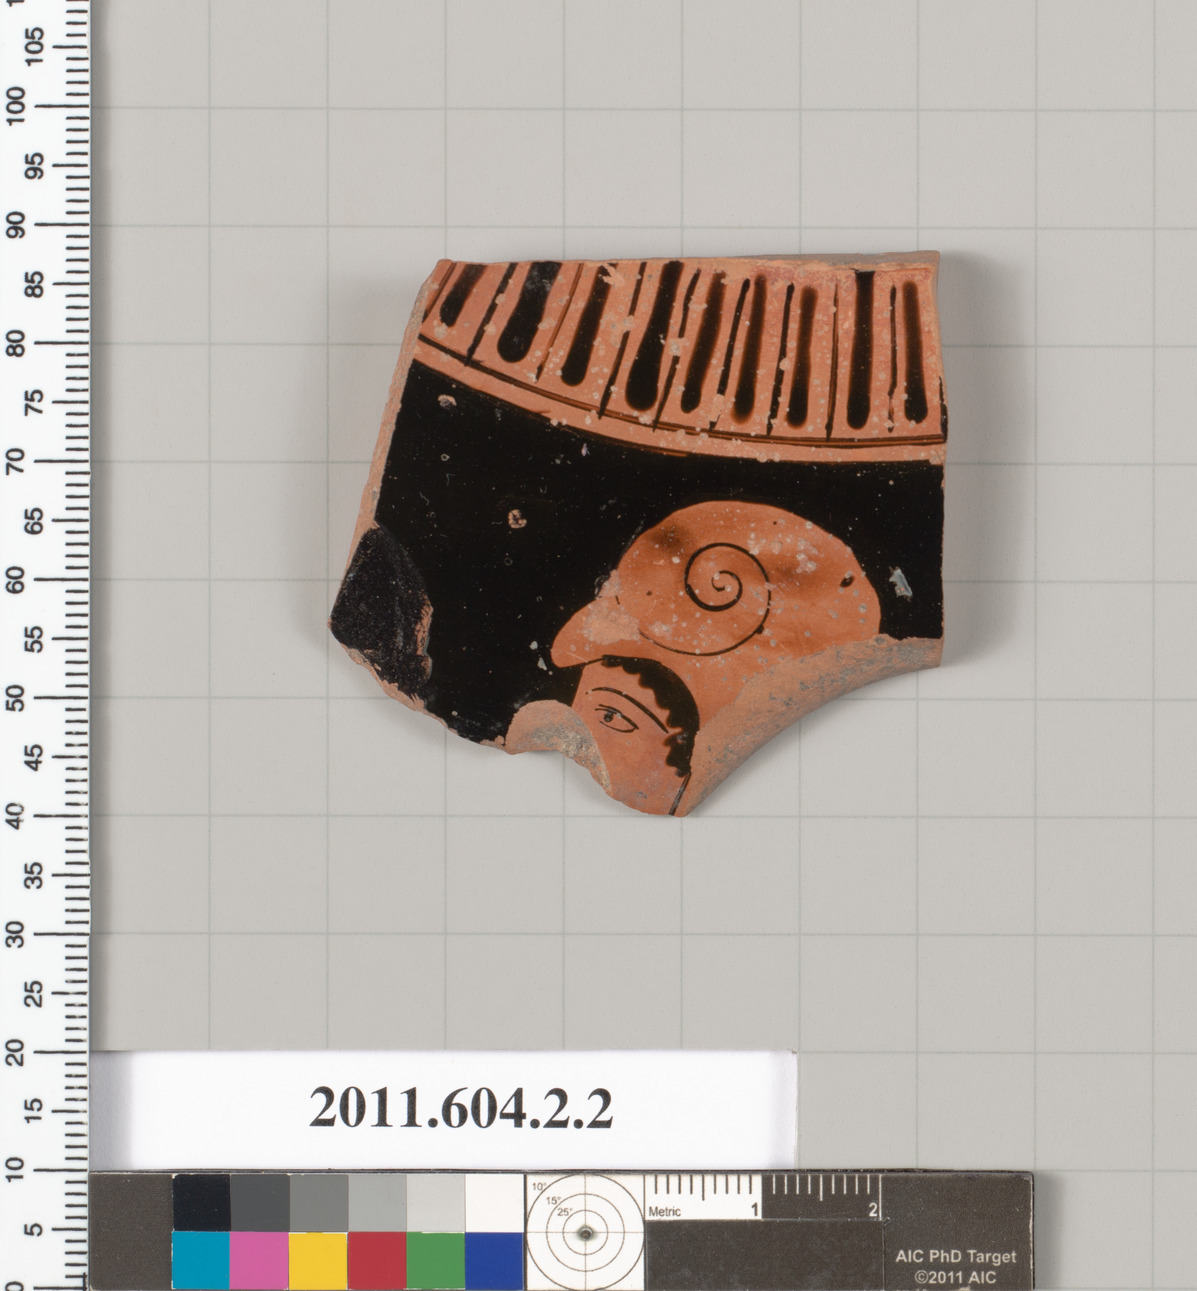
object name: neck amphora fragment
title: Terracotta fragment of a neck-amphora (jar)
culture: greek, attic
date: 480-470 BCE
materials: terracotta